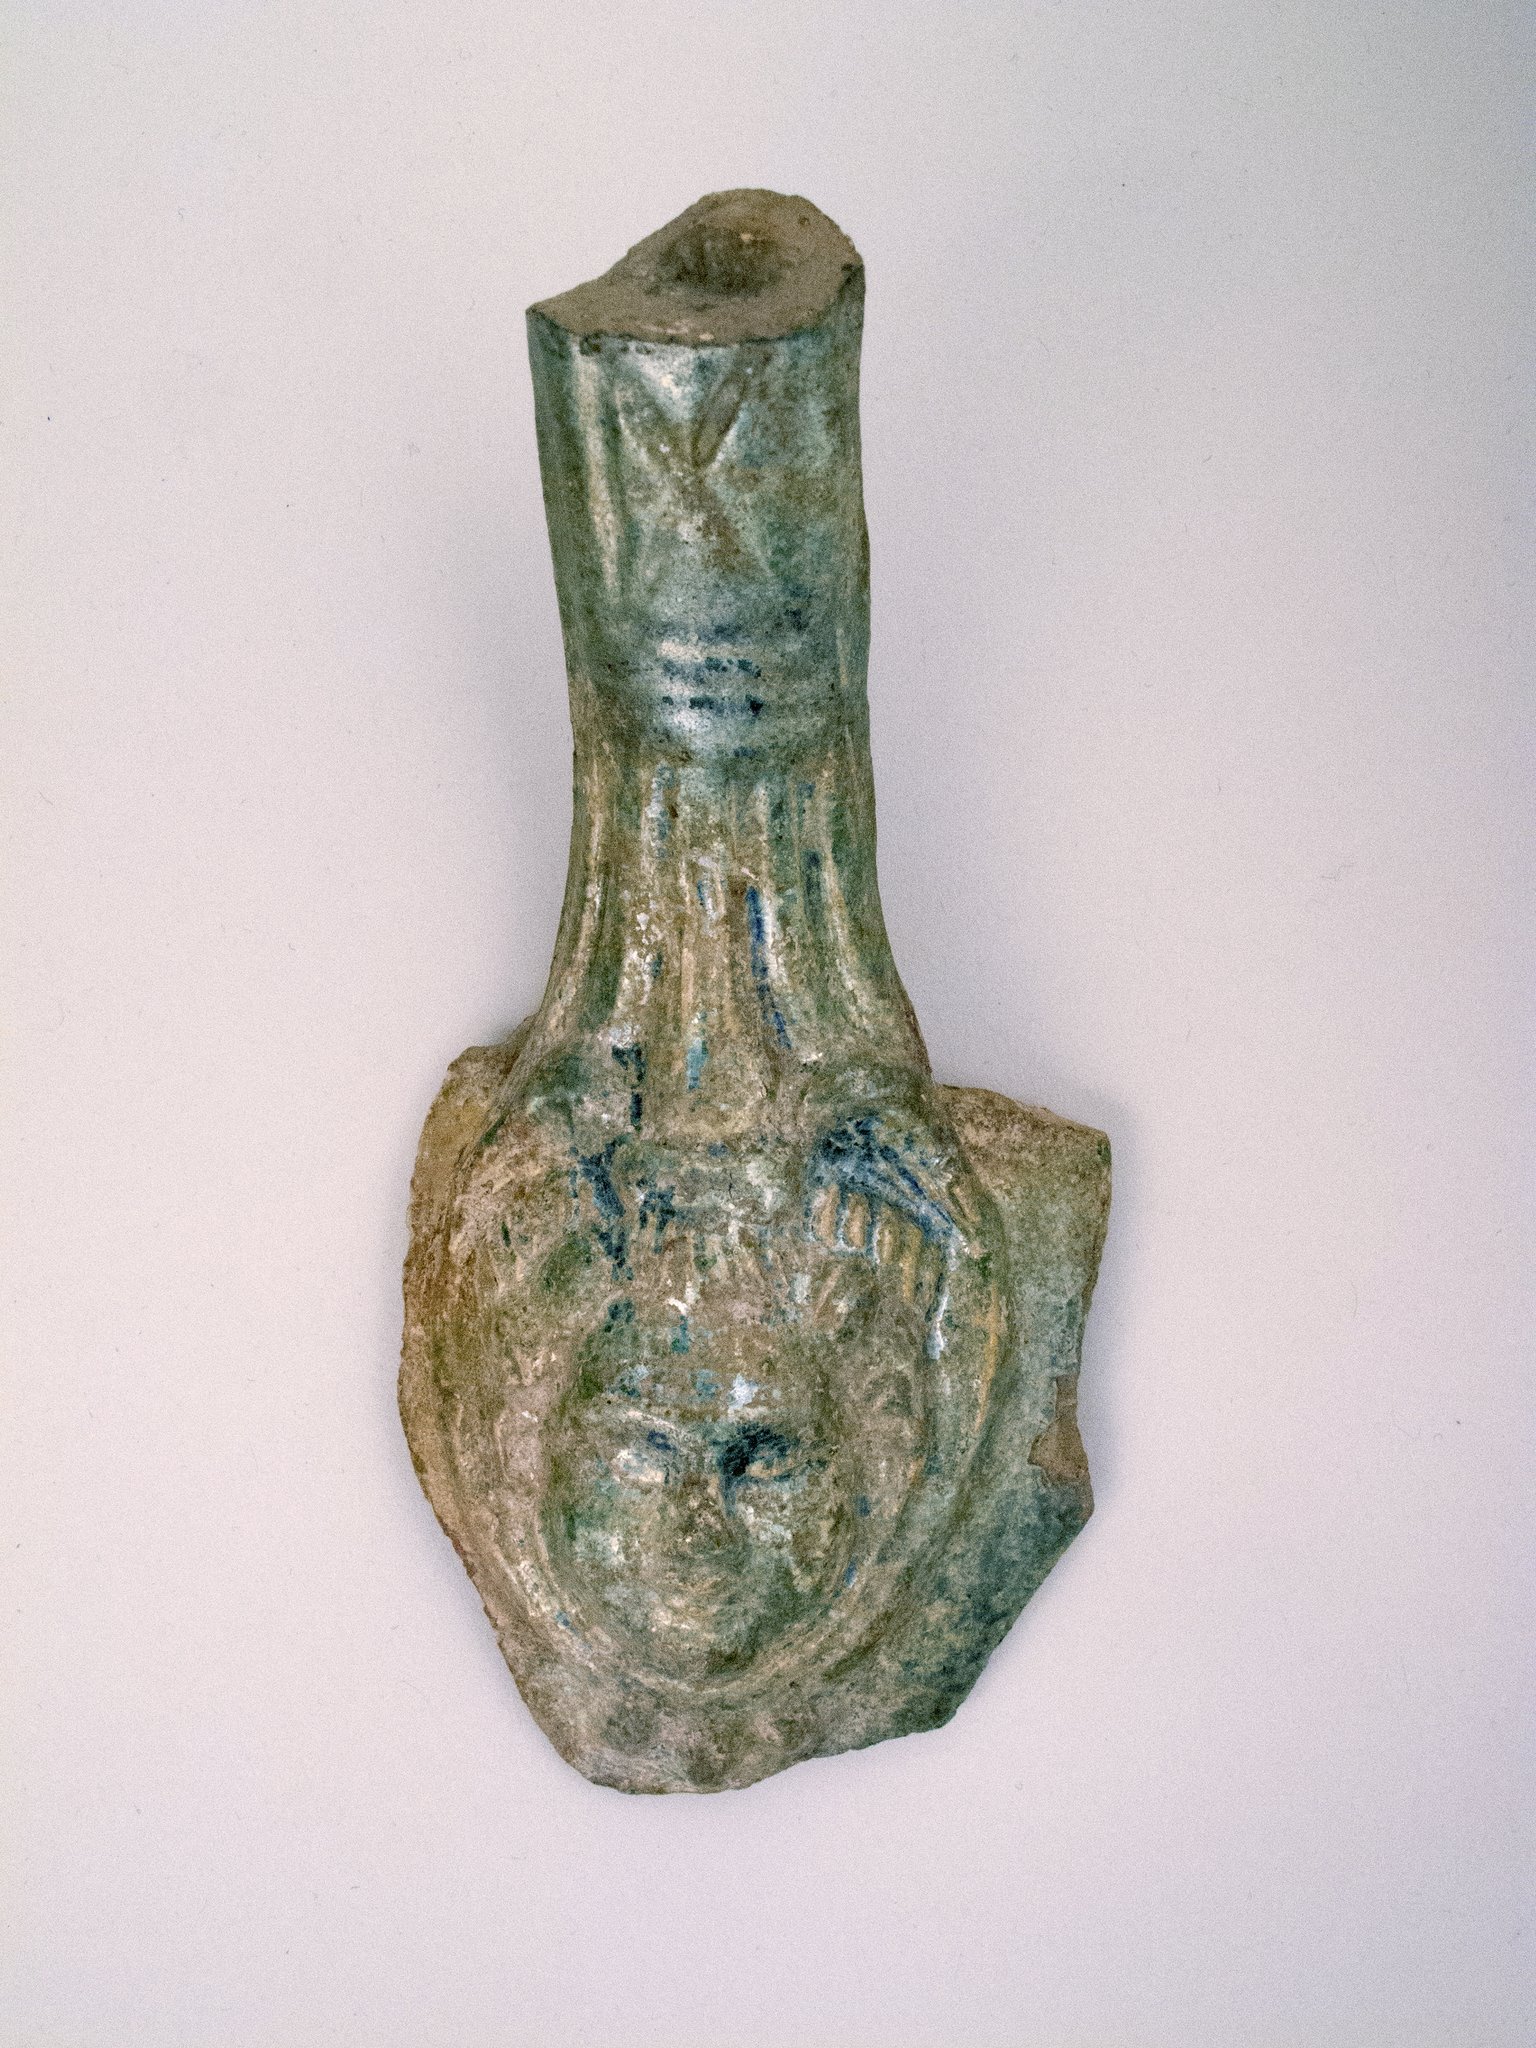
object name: vase fragment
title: Terracotta green-glazed jug handle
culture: roman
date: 50-100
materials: terracotta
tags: faces